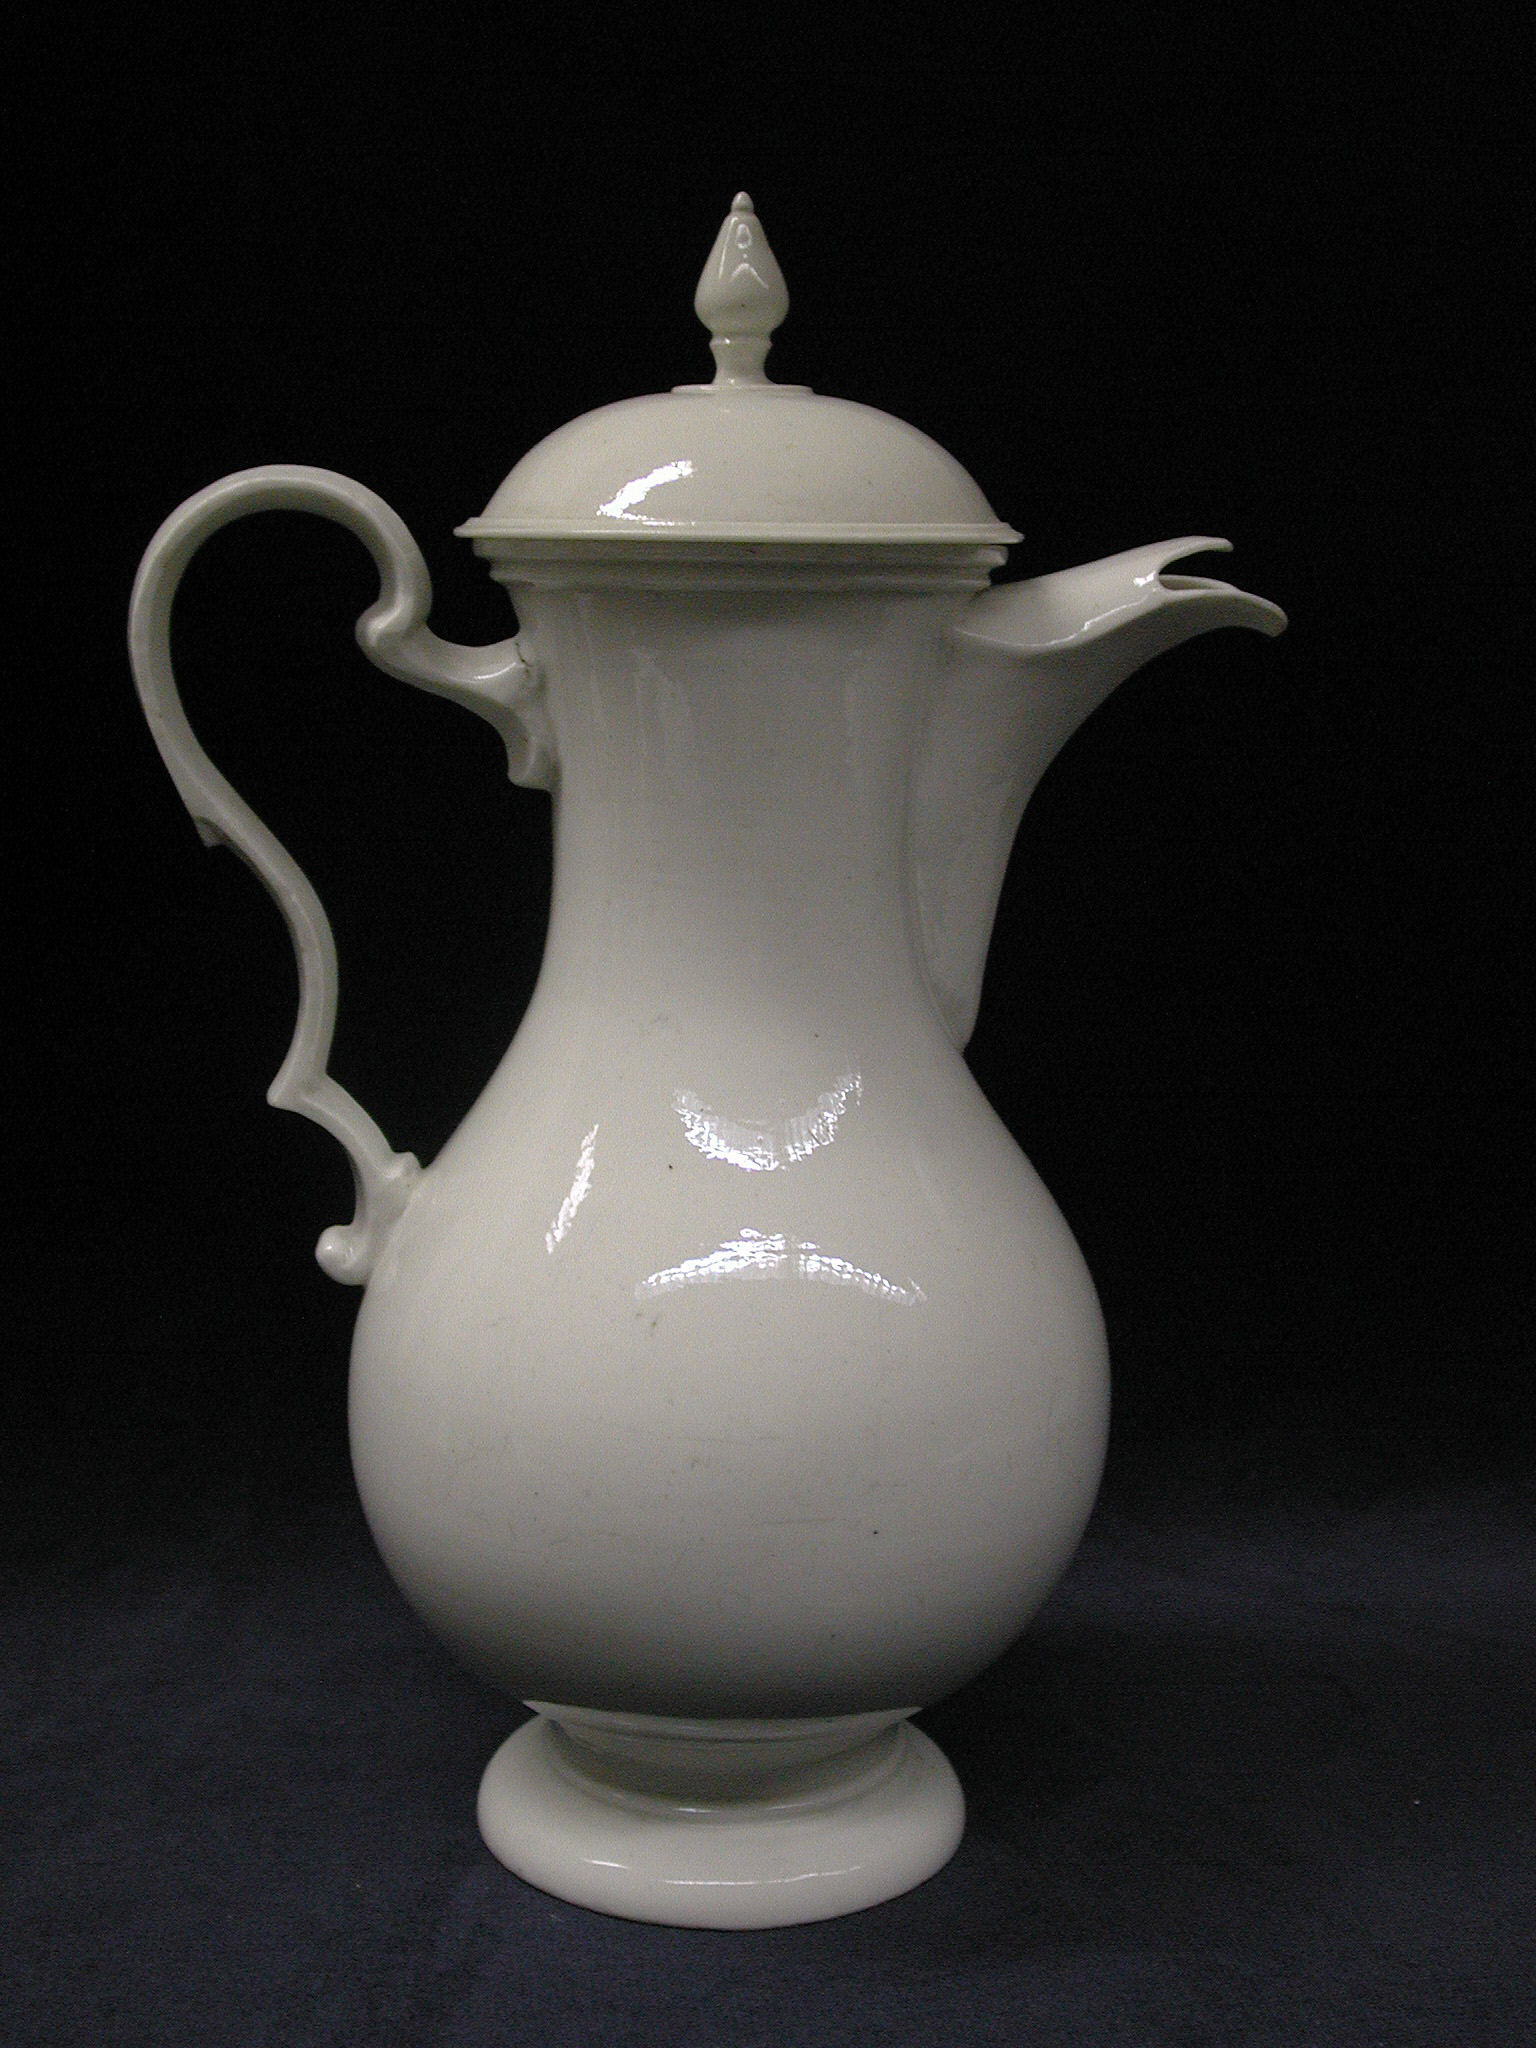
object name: coffeepot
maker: capodimonte porcelain manufactory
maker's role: manufactory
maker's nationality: italian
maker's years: 1740-1759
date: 1745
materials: soft paste porcelain